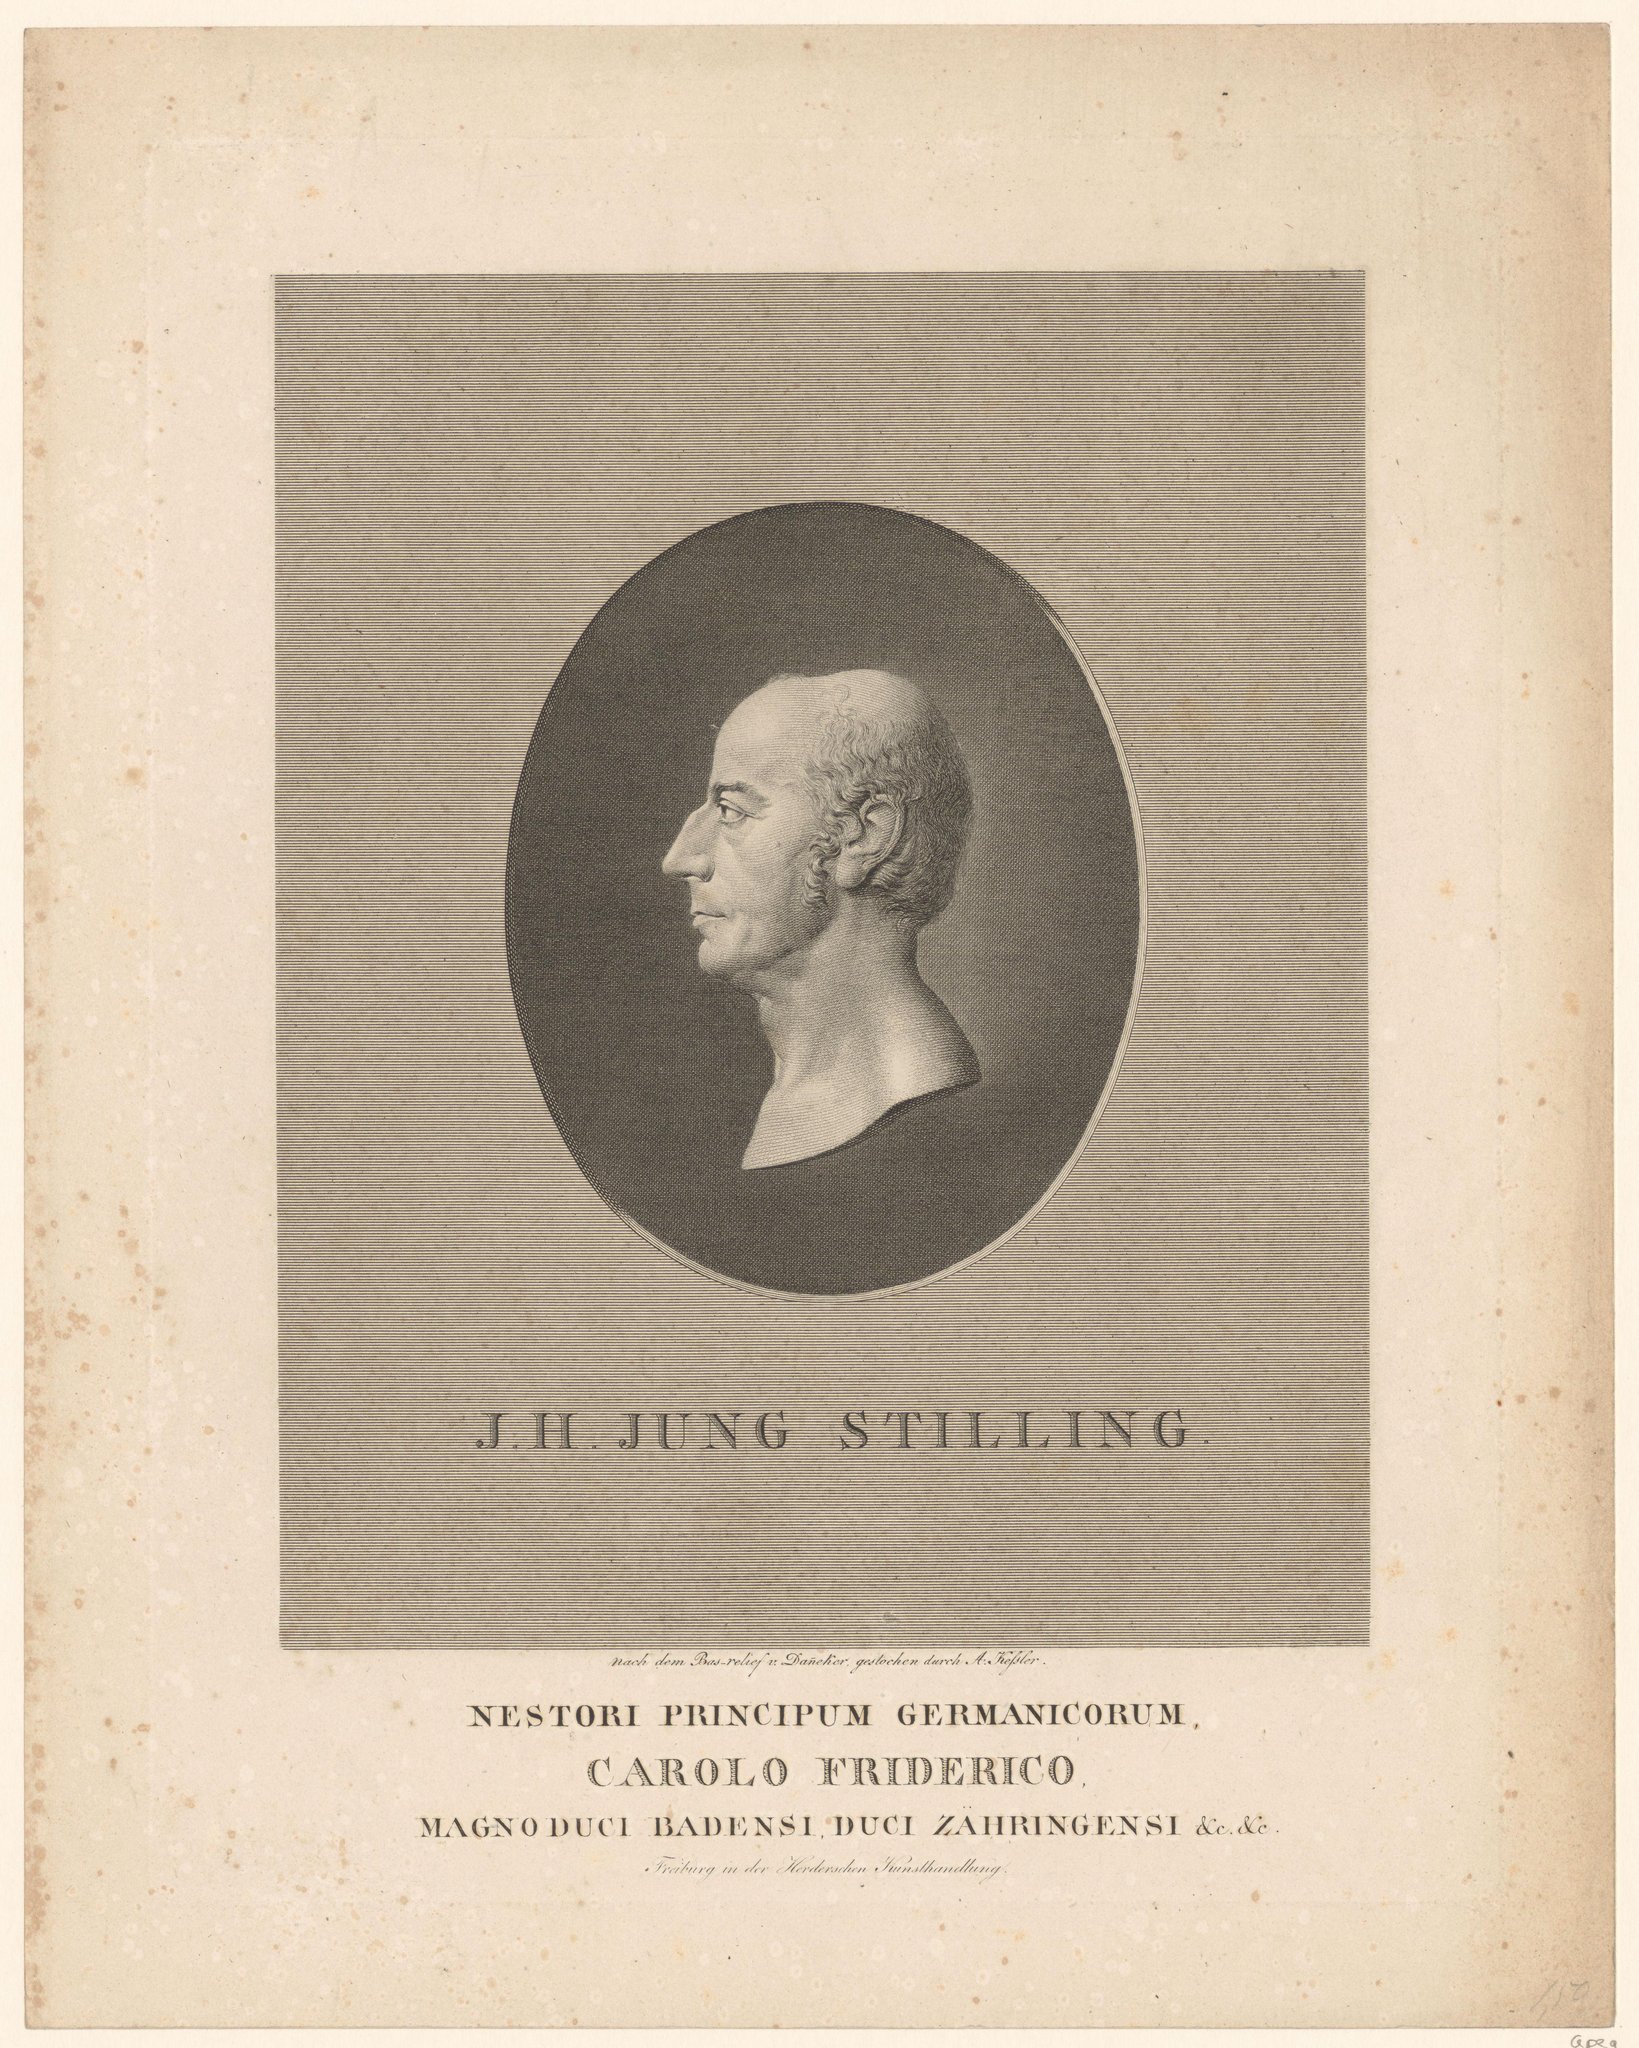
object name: print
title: Portret van Johann Heinrich Jung-Stilling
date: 1787-1820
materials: paper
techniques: engraving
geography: stuttgart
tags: historical persons, portrait of a writer, physician, doctor (+ portrait of scholar, scientist)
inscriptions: collector's mark: Lugt 2233